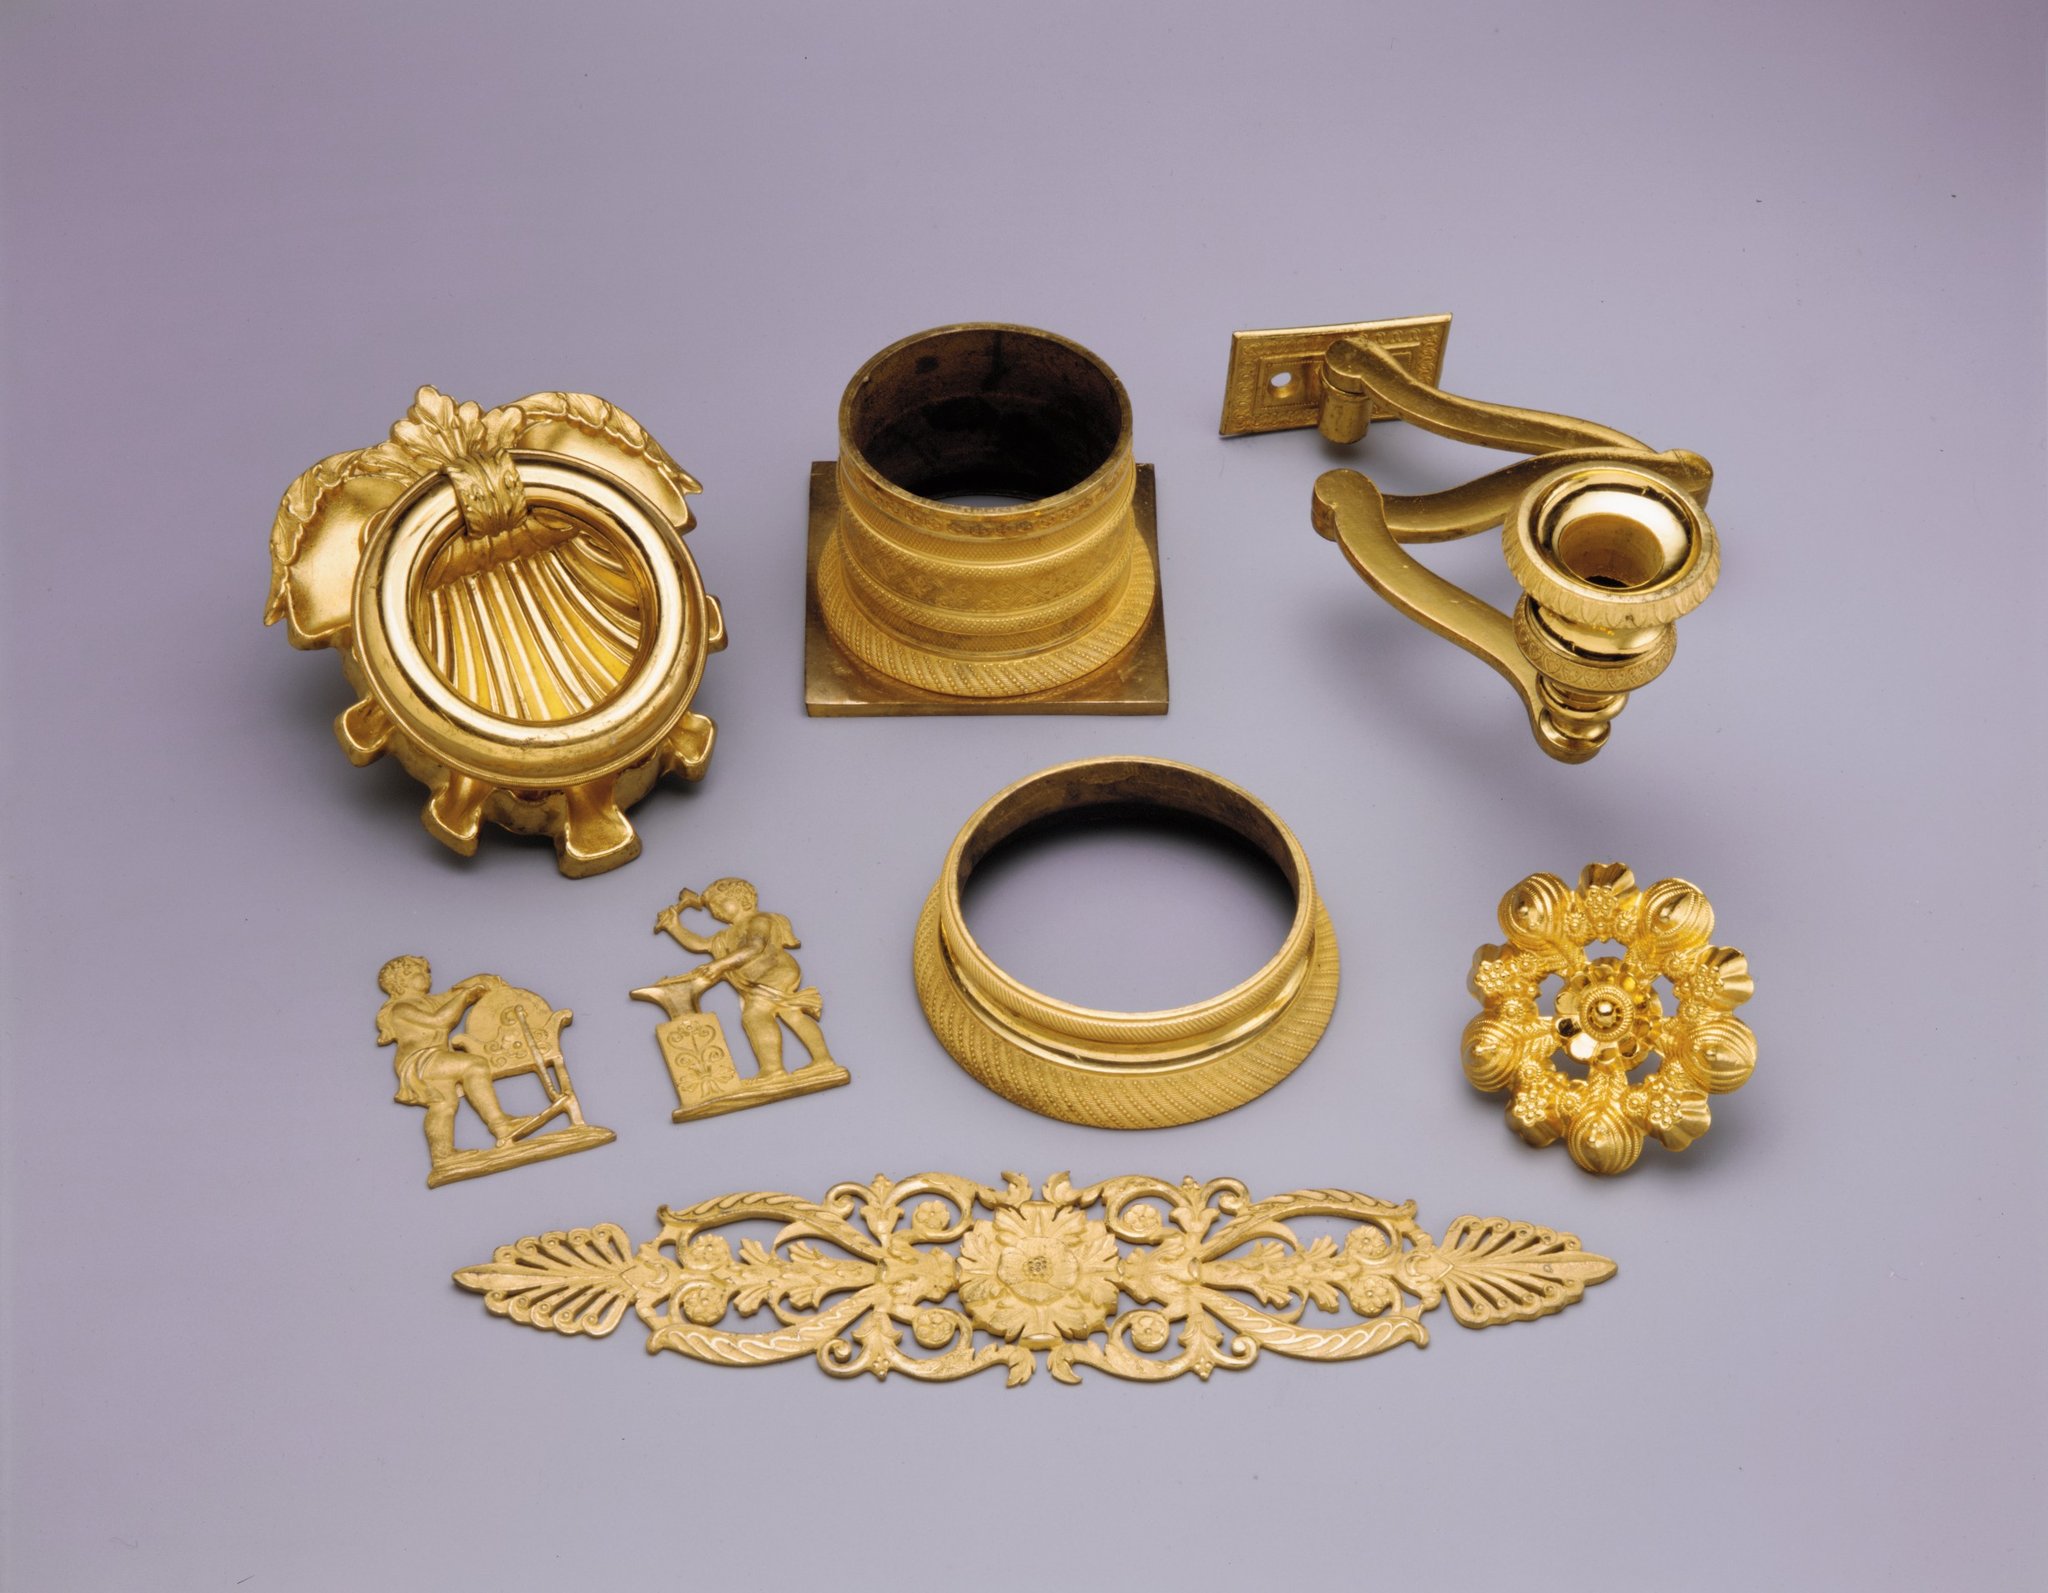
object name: furniture hardware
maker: henry kellam hancock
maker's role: retailer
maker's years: 1816-1851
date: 1820-1830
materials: brass, gilt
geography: france